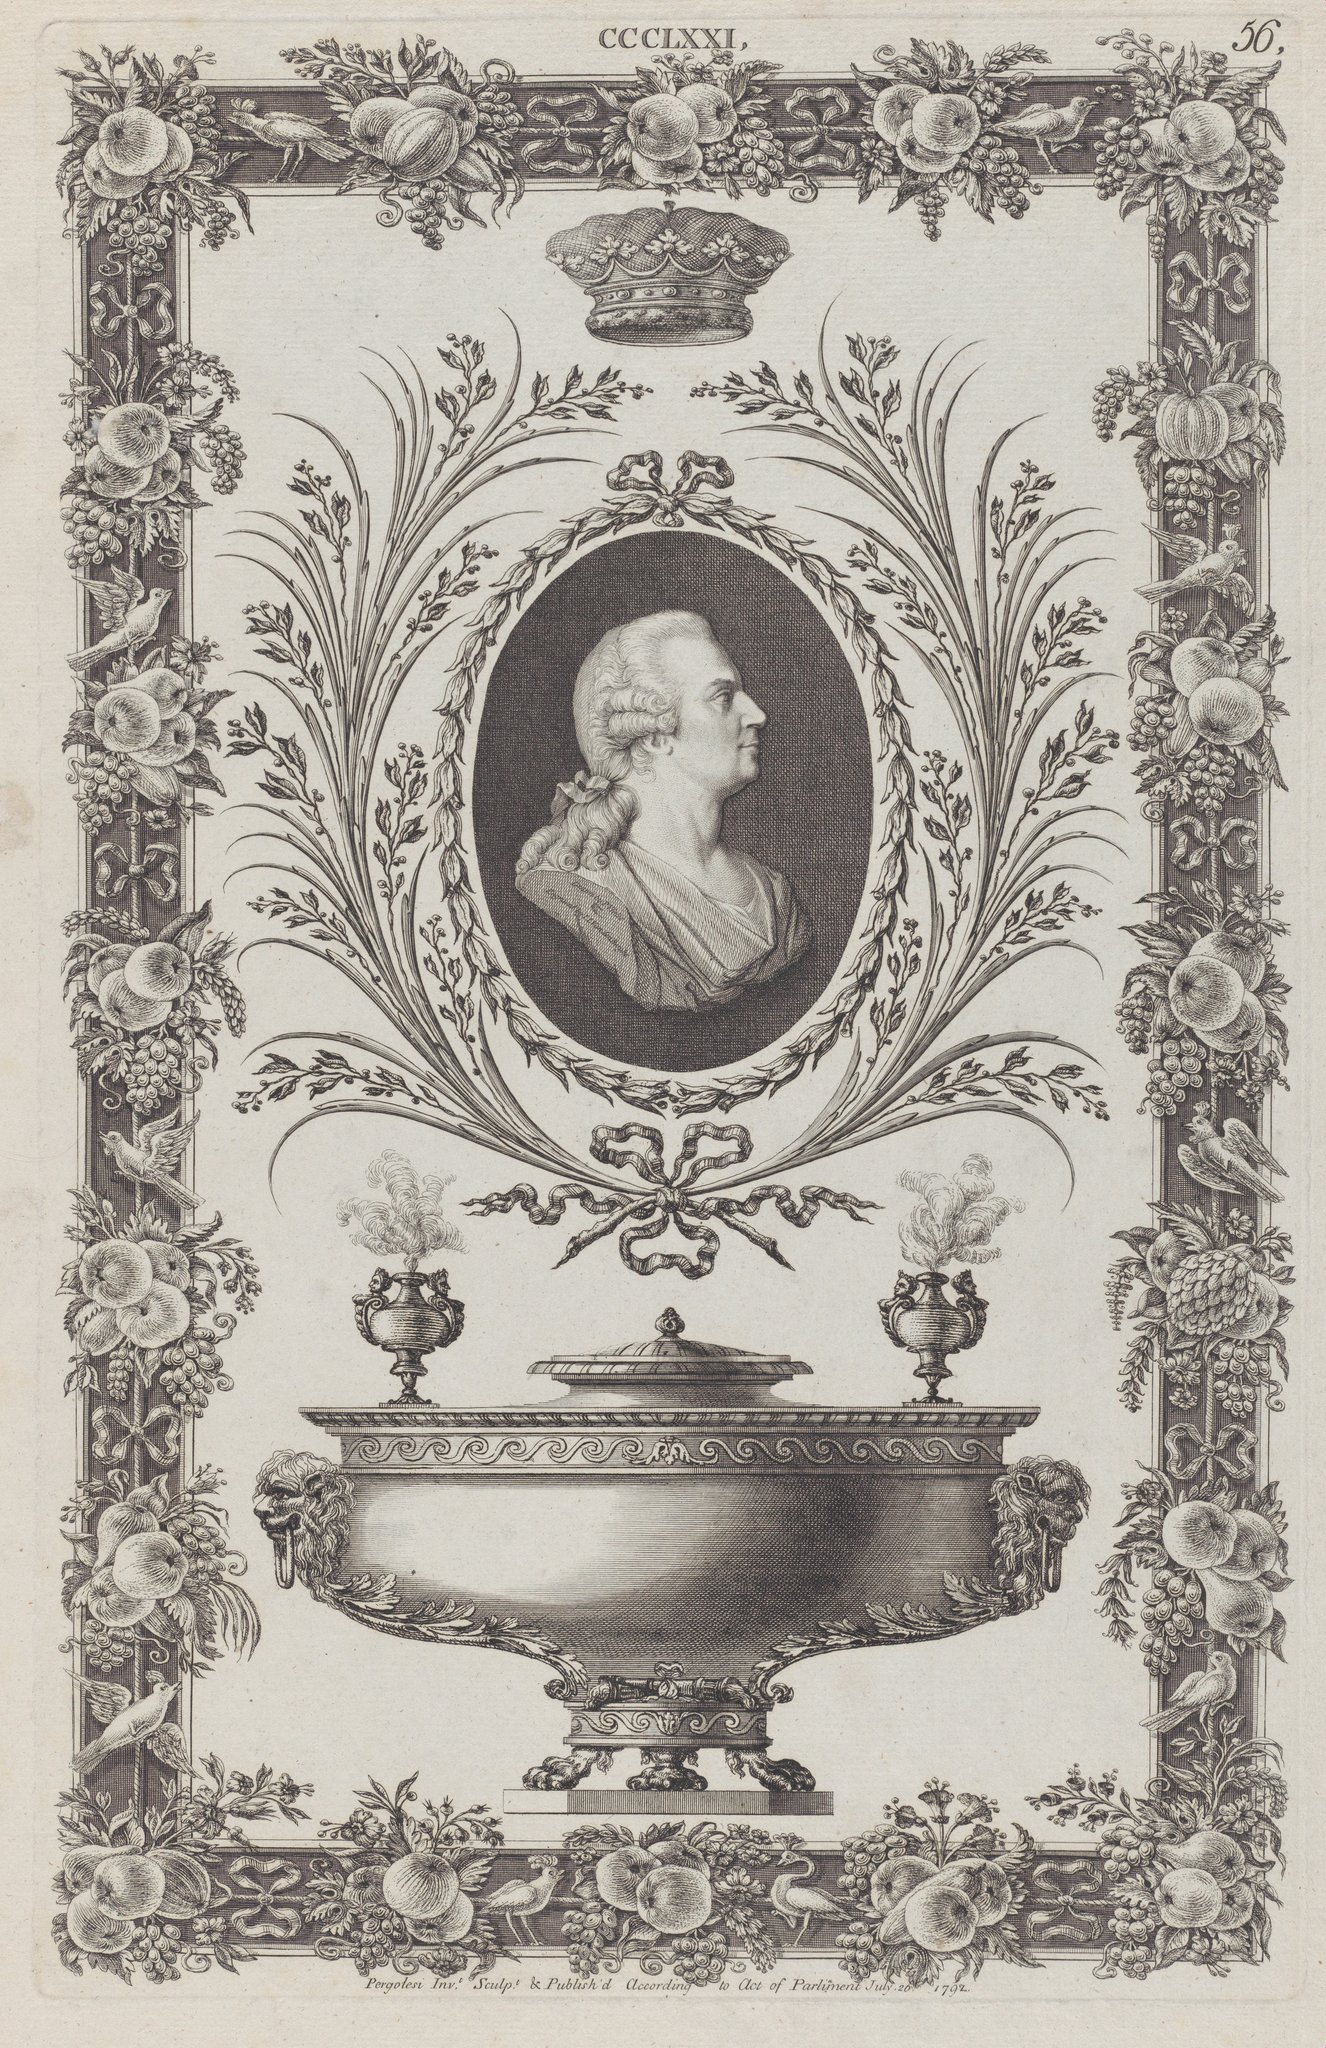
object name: print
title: Portrait of the Duke of Northumberland, Vase and Ornamental Frame, no. CCCLXXI, plate 56 from "Designs for Various Ornaments"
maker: michelangelo pergolesi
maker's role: artist and publisher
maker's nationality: italian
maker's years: 1760-1801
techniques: etching